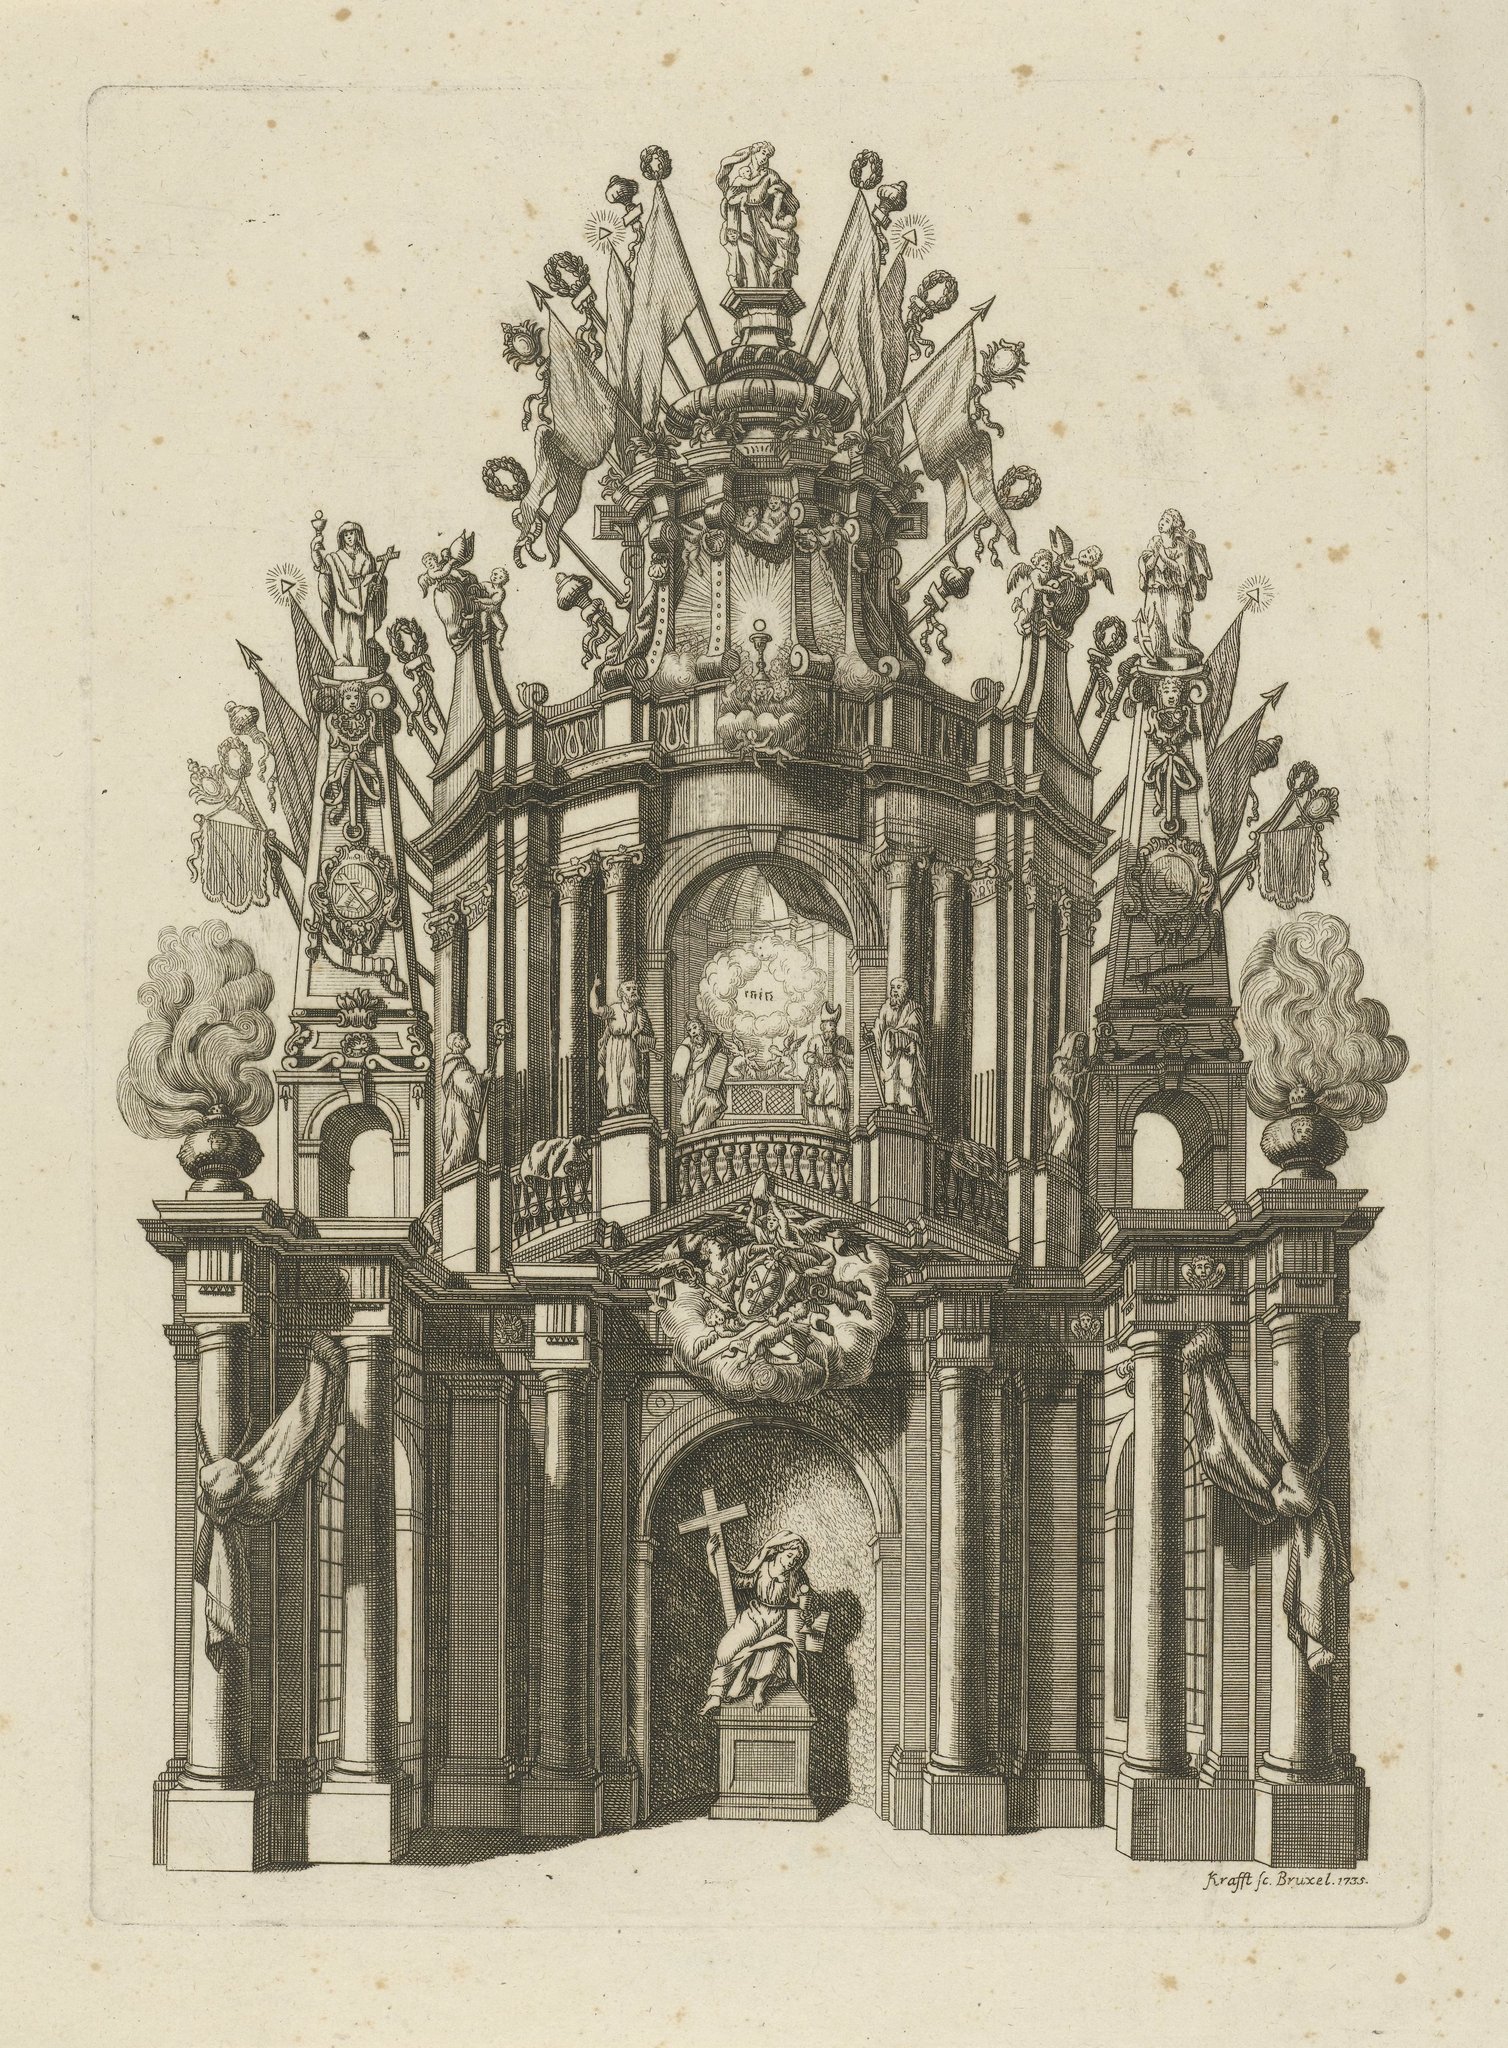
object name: print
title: Fantasiemonument voor de Heilige Sacramentskapel in Brussel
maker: jan lauwryn krafft (i)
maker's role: print maker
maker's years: 1694-1785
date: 1735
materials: paper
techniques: engraving, etching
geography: brussels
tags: monument, statue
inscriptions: collector's mark: Lugt 2228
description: Fantasiemonument in barokstijl voor de Heilige Sacramentskapel ter ere van het mirakel van Brussel. Het altaar bestaat uit drie verdiepingen, met beelden van diverse heiligen, twee wierookvaten en vele vaandels.